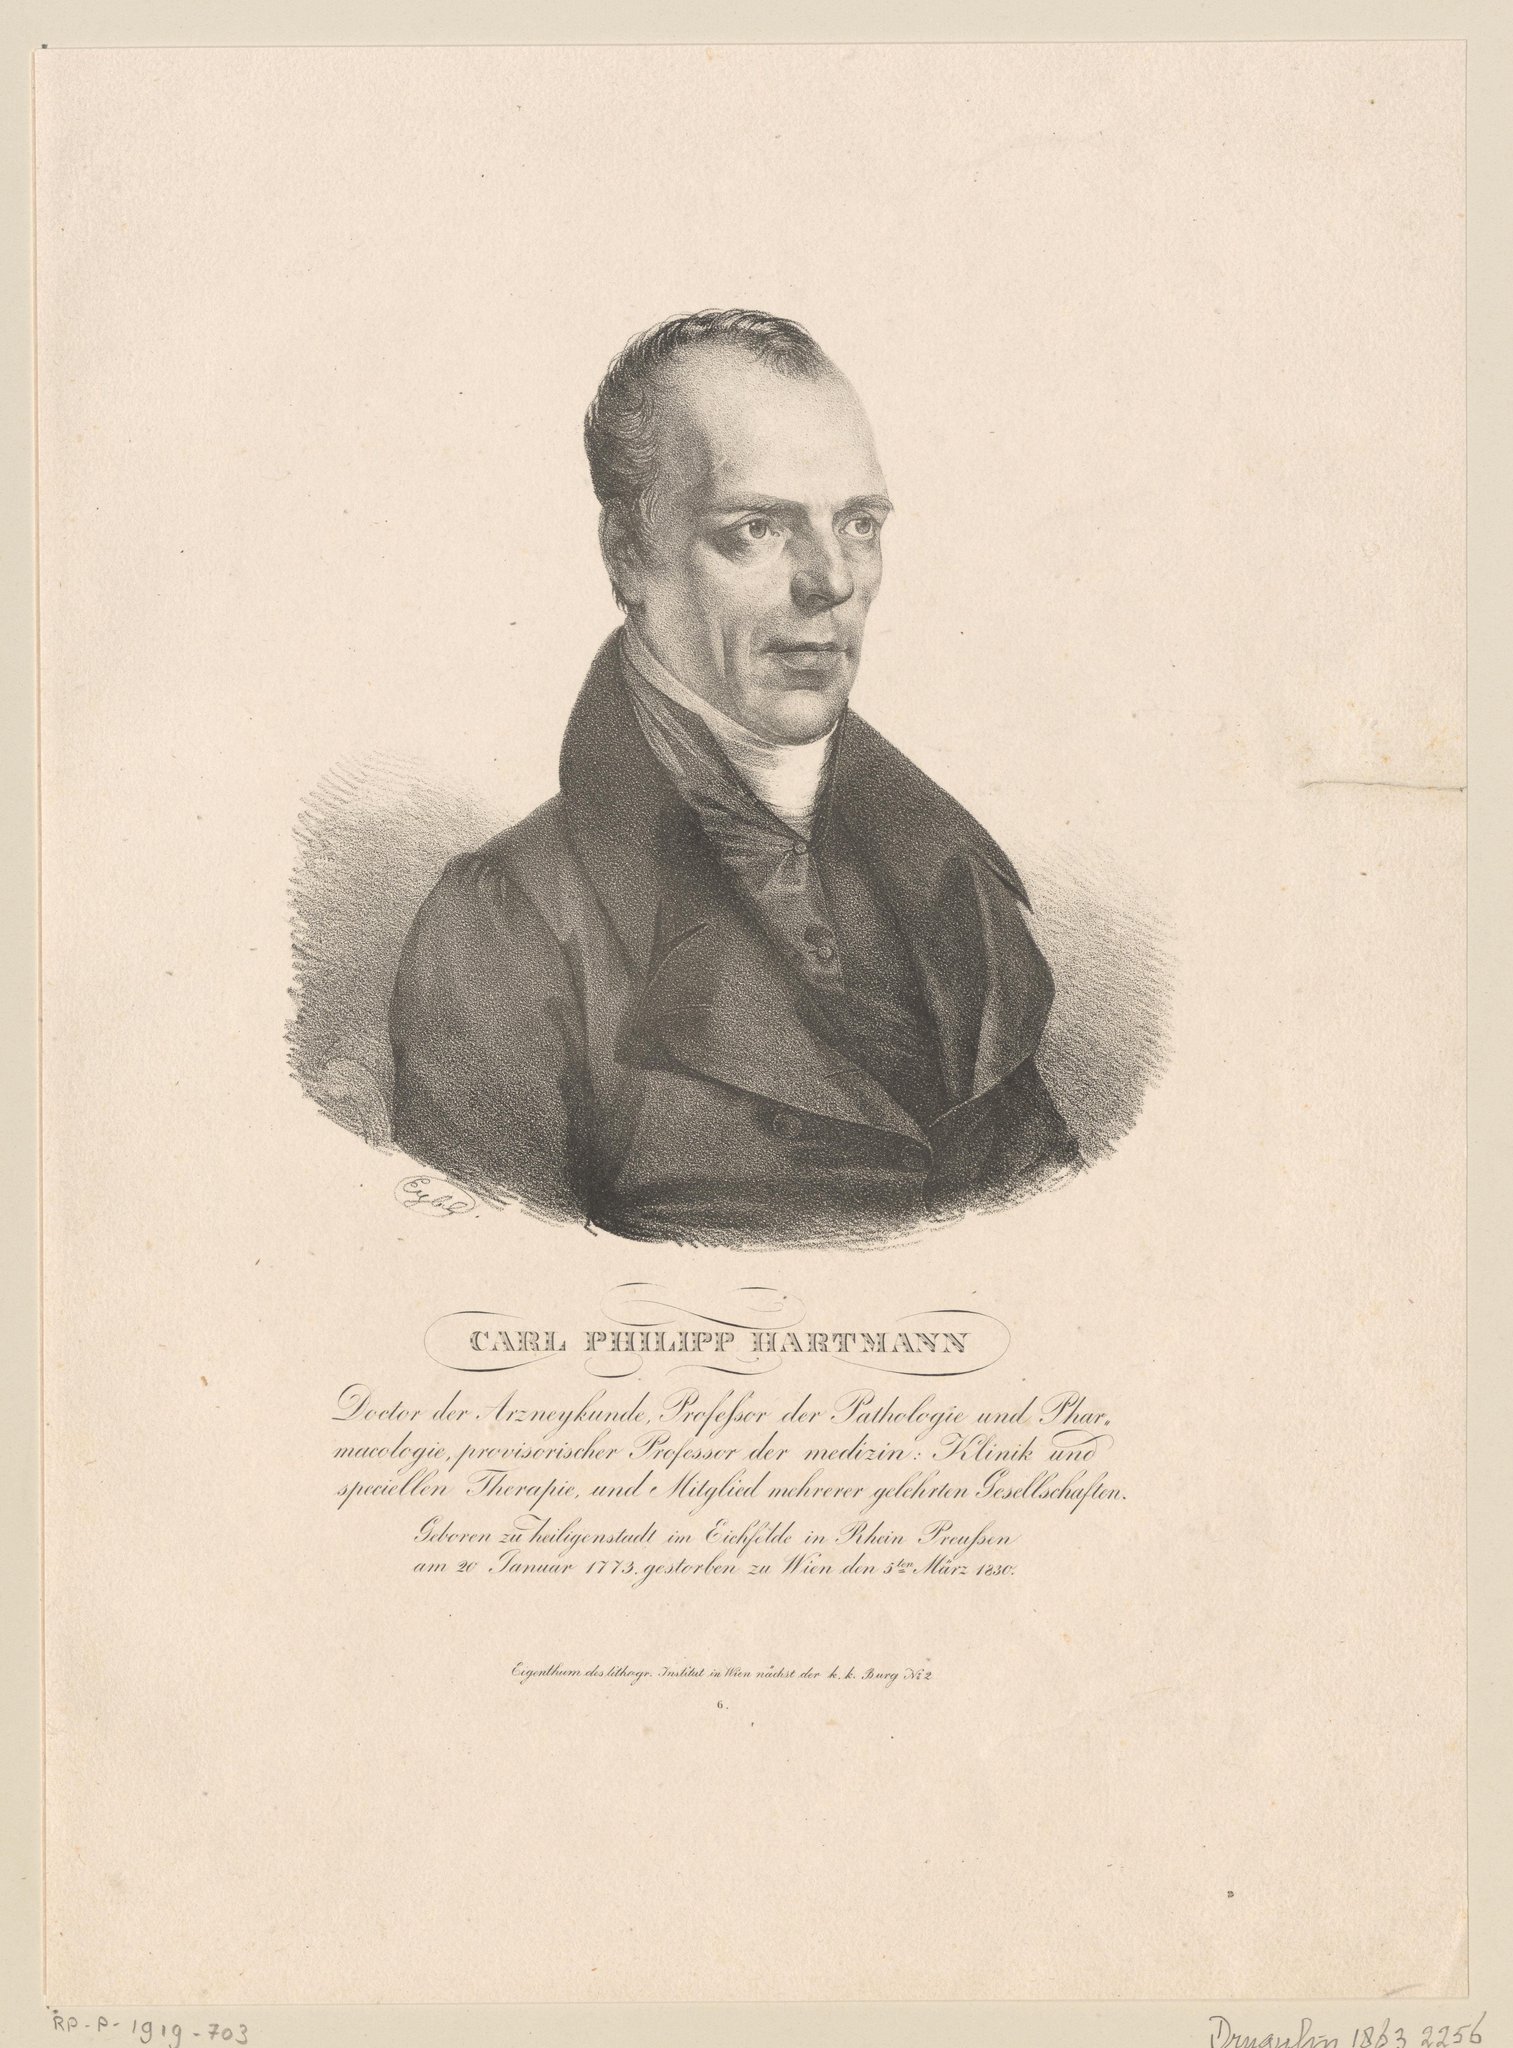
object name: print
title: Portret van Philipp Karl Hartmann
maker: franz eybl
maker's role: print maker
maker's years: 1806-1880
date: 1830-1880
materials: paper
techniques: lithograph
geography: vienna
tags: historical persons, physician, doctor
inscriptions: collector's mark: Lugt 2228